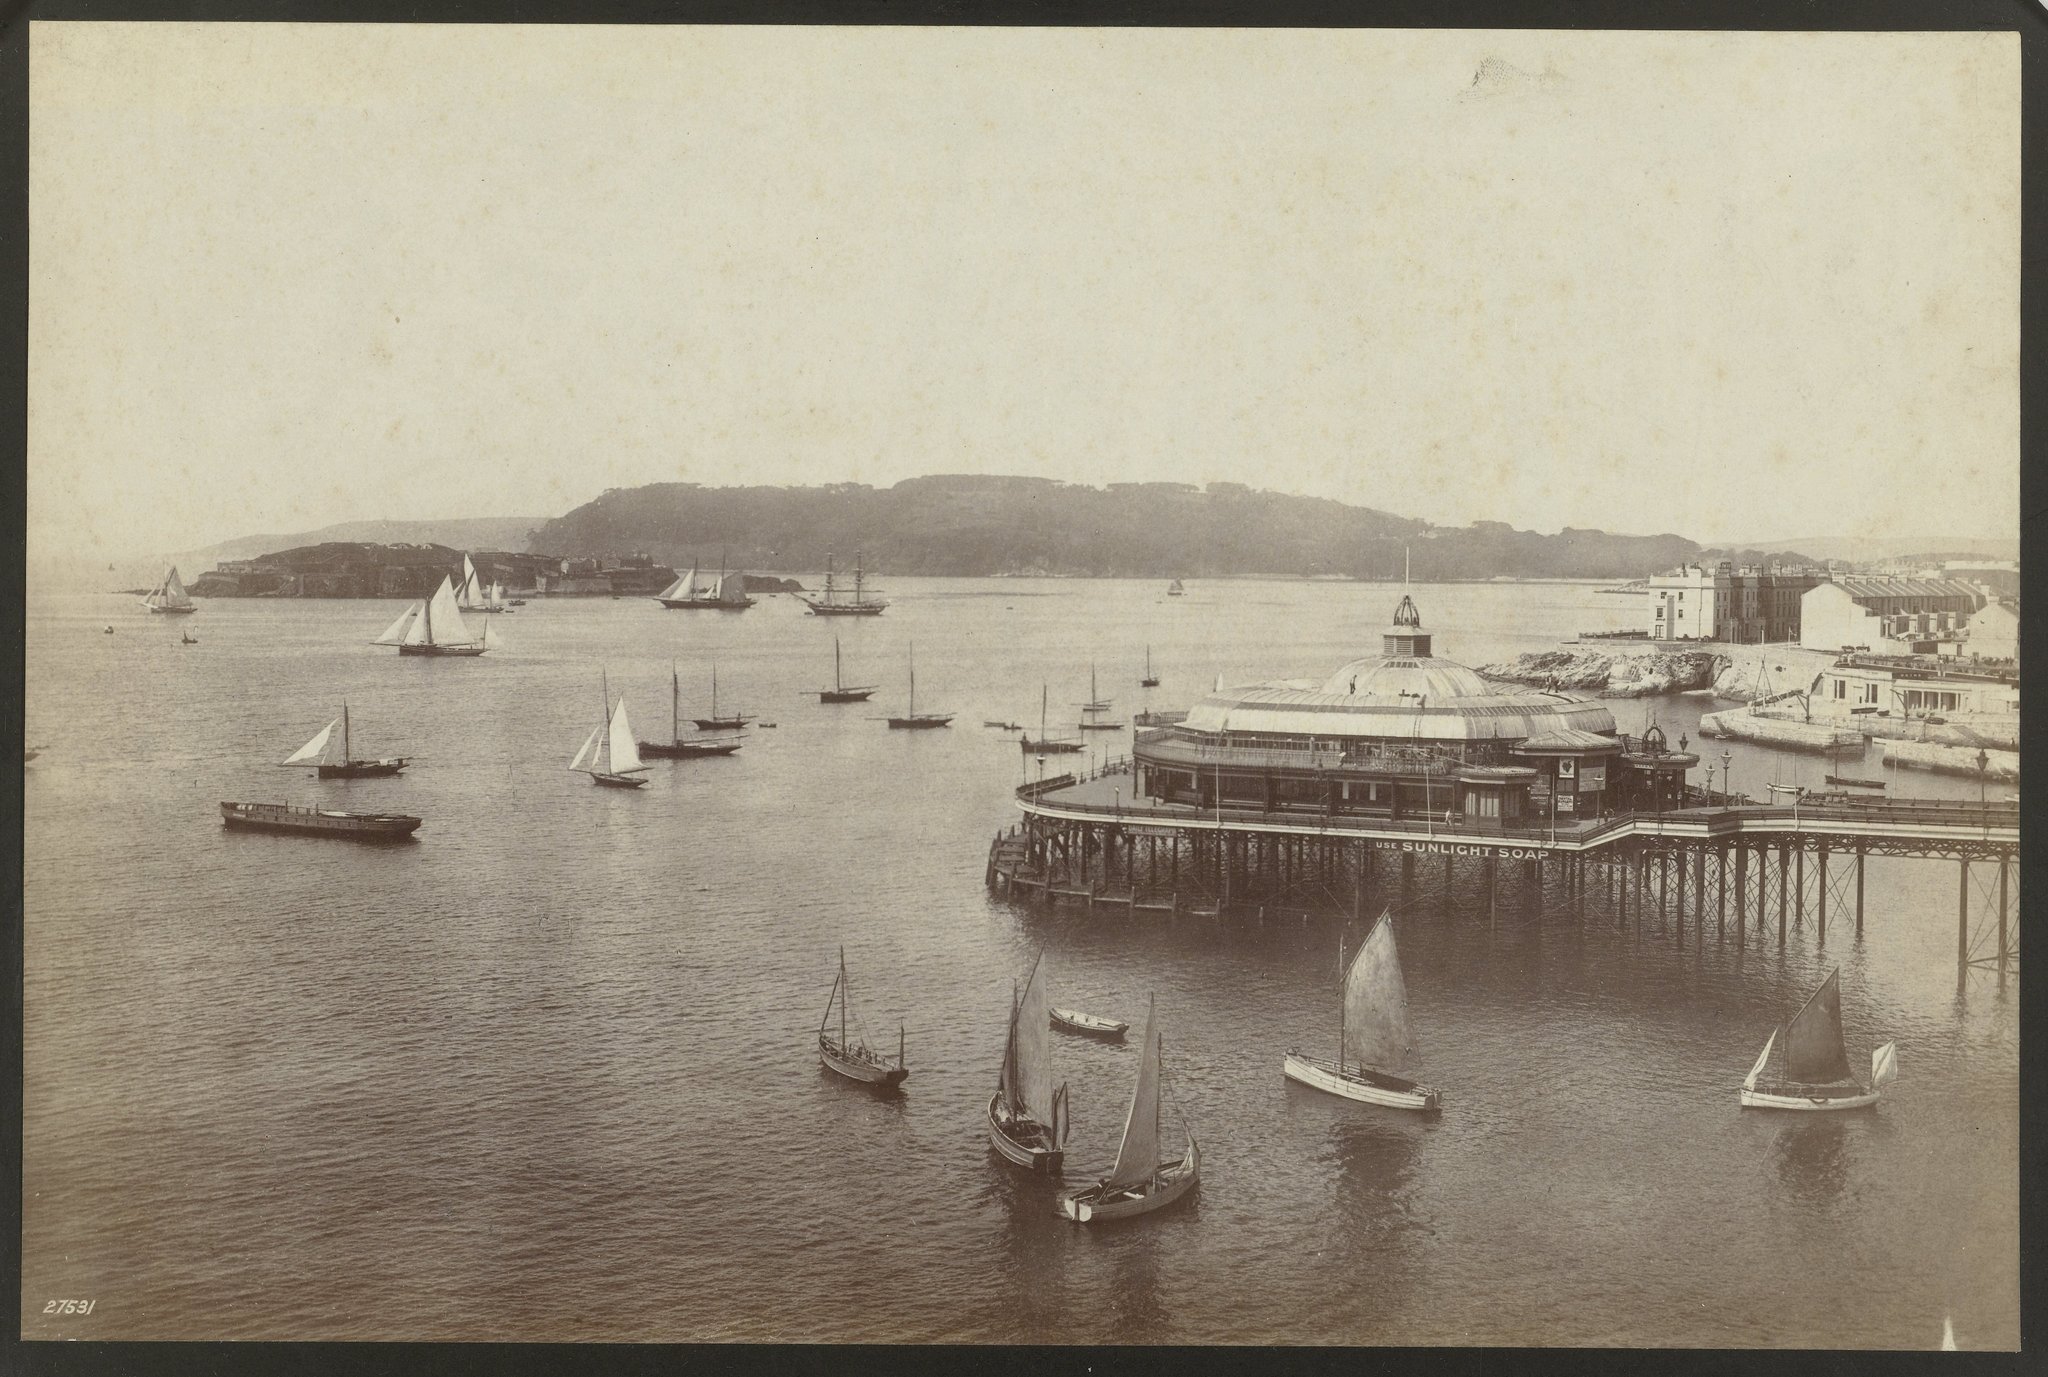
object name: photograph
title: Plymouth Pier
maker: Anonymous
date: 1880-1900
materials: cardboard, paper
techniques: albumen print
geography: great britain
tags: ships (in general) - cc - more than one ship, pier, quay, wharf, plymouth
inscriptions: number: ‘27531’